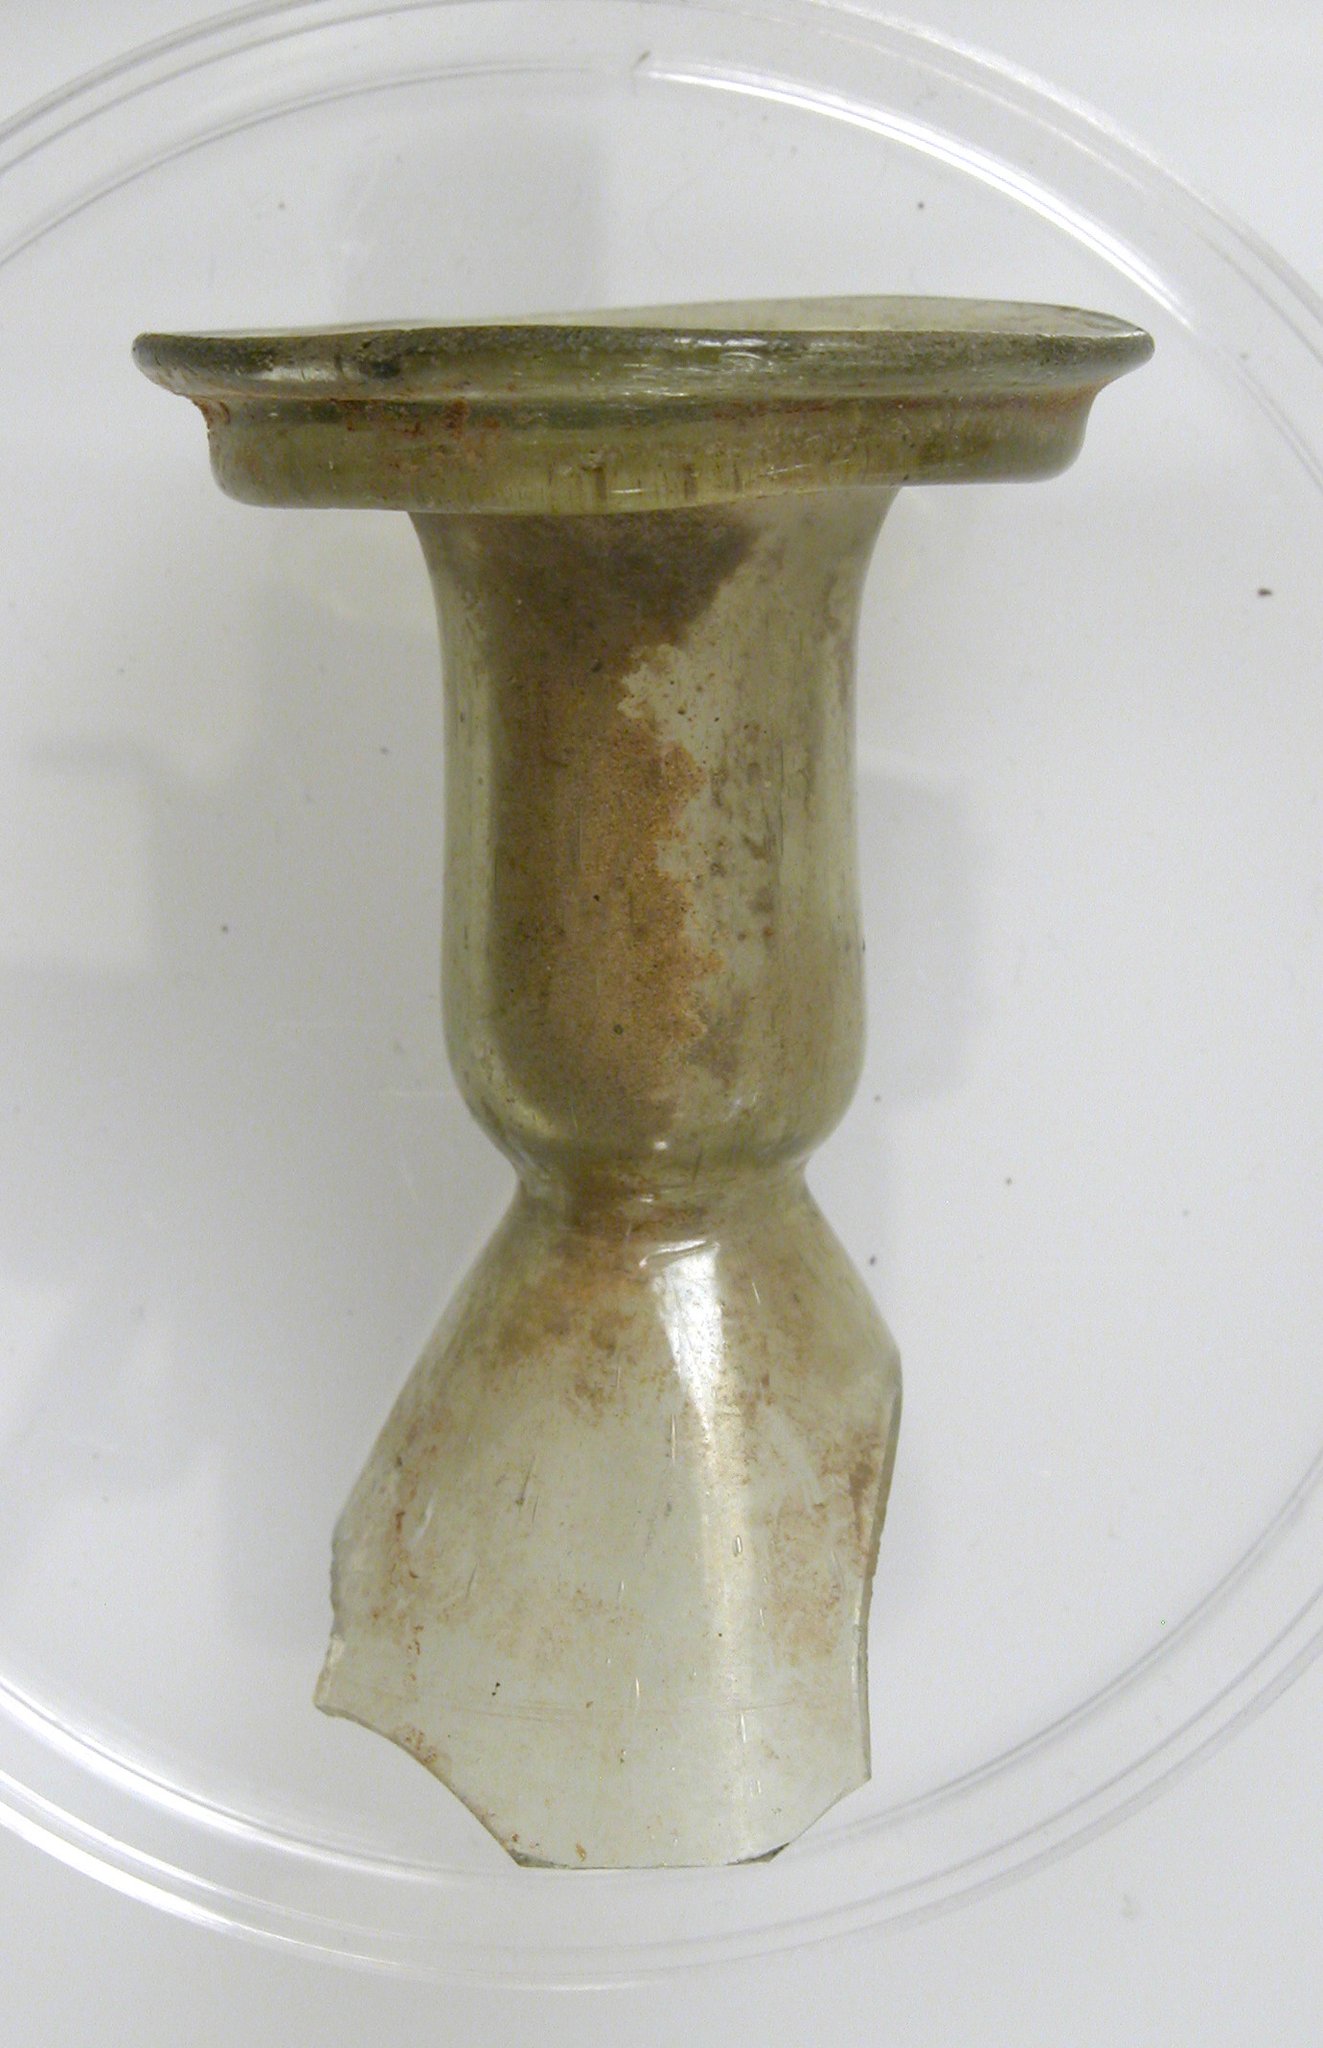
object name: fragment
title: Neck and Rim of a Vessel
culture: coptic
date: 301-433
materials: glass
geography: egypt